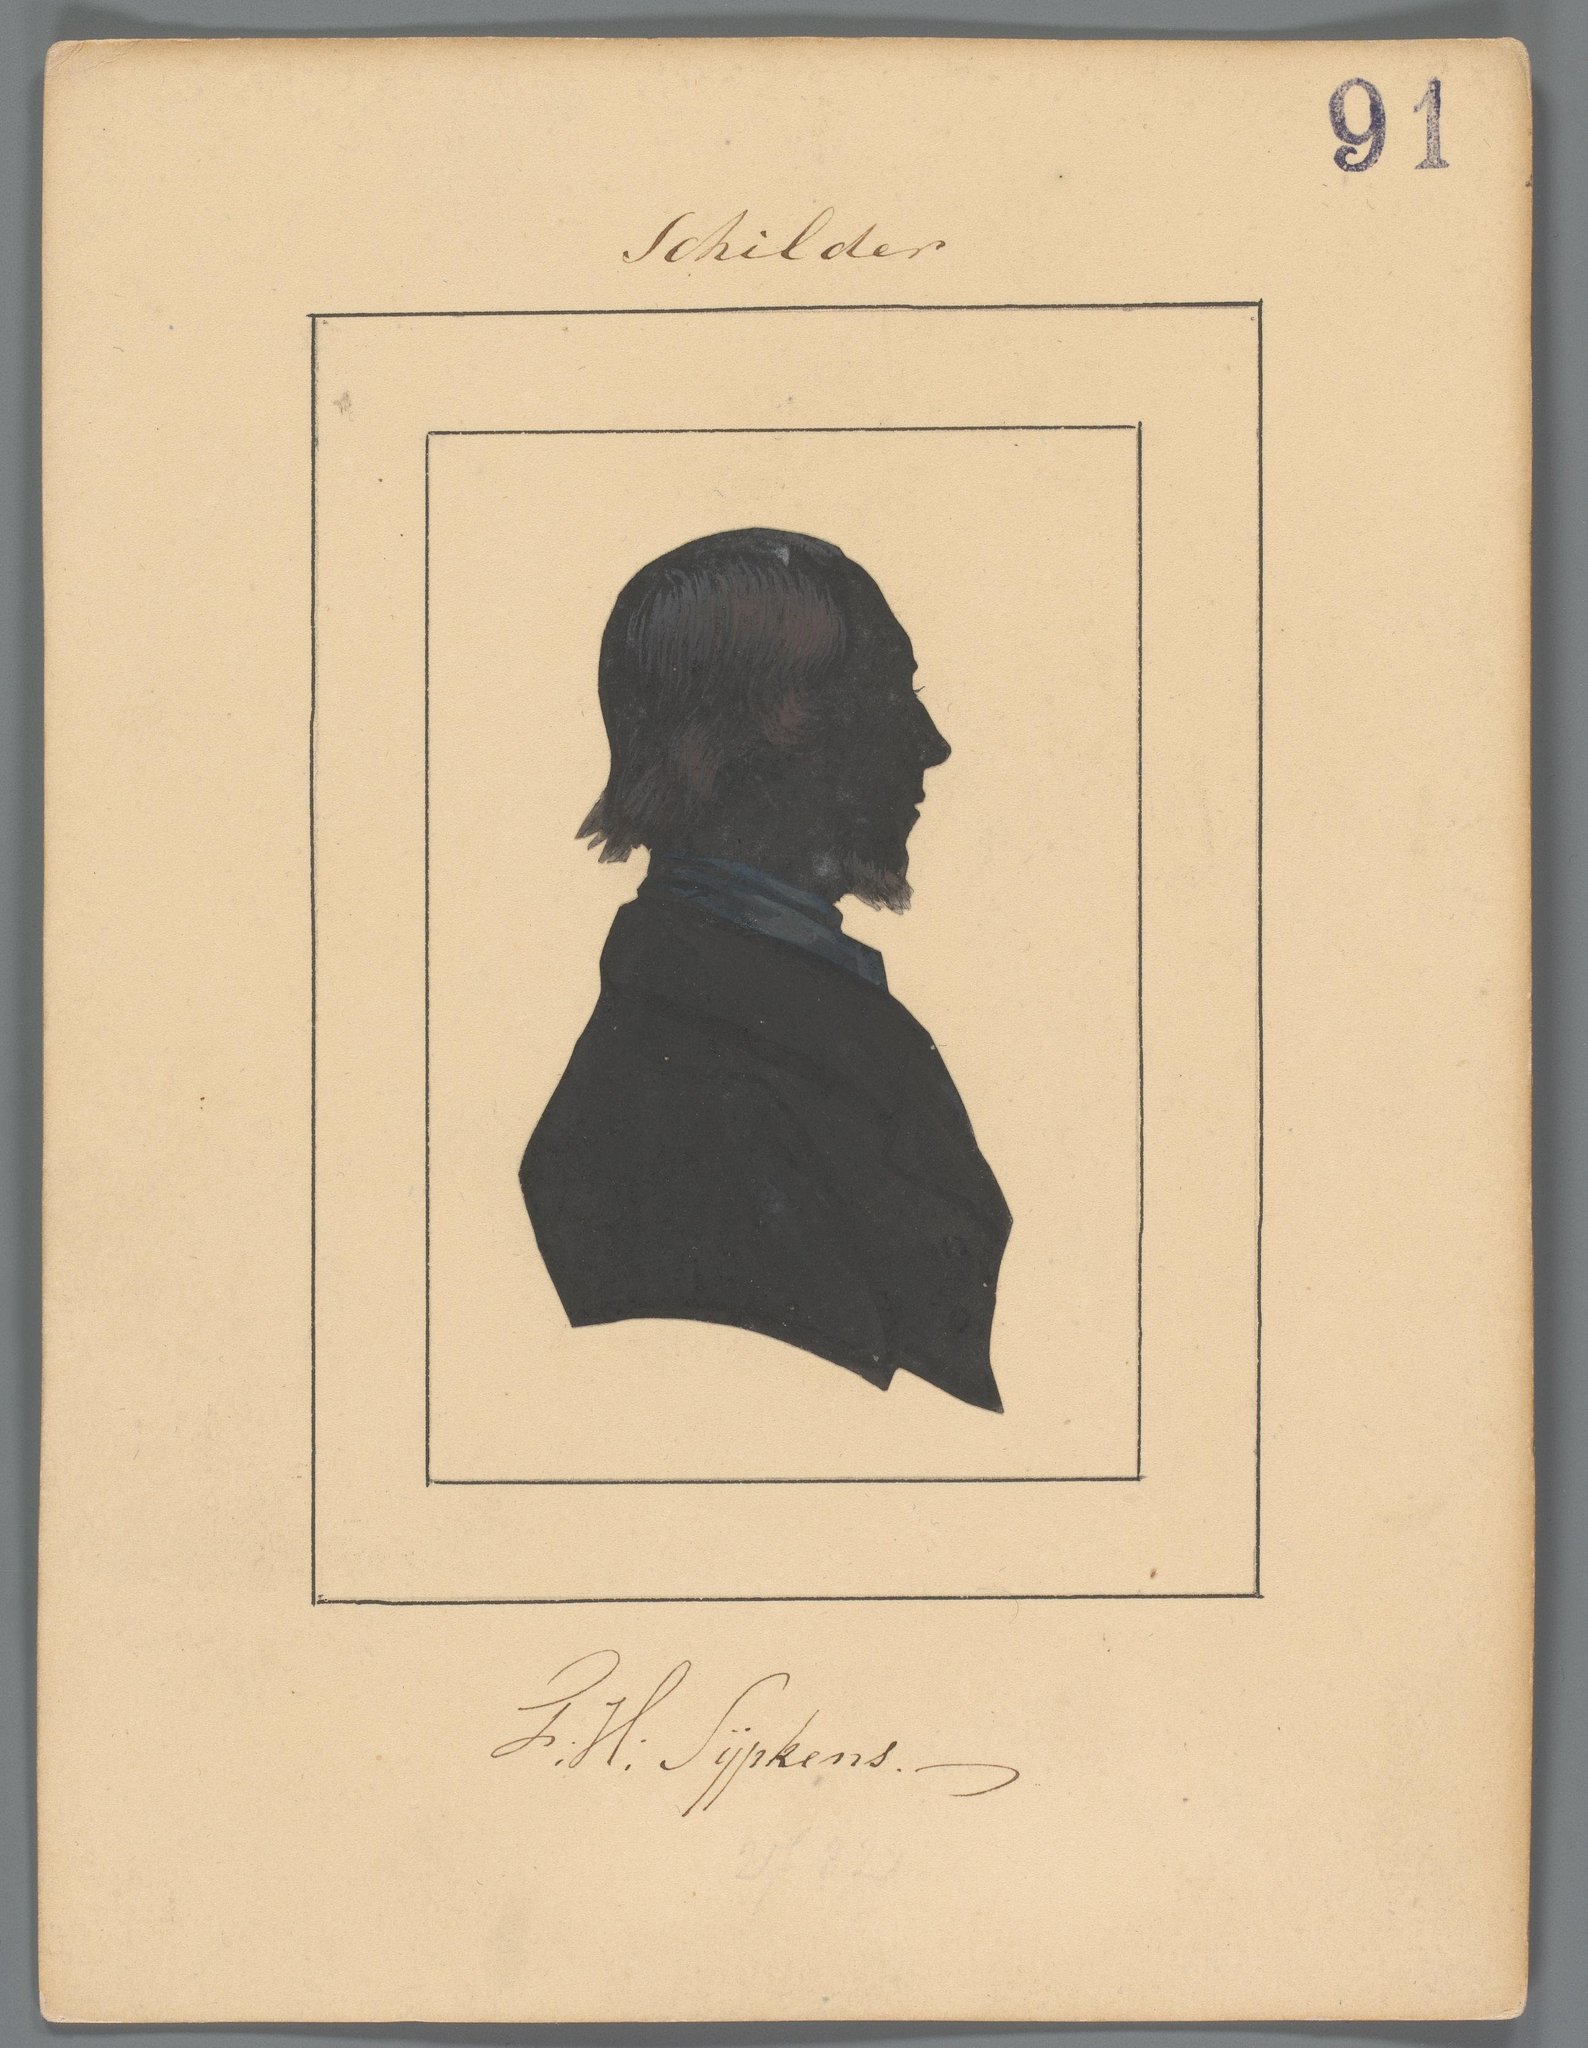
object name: silhouette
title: Silhouetportret van Ferdinand Hendrik Sijpkens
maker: elisabeth alida haanen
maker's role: draughtsman, print maker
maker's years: 1809-1845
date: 1819-1845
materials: ink, paint, paper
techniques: brush, snipping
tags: ferdinand hendrik sijpkens, historical persons, portrait, self-portrait of painter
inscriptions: number: ‘91’, inscription: ‘F:H: Sijpkens.’, collector's mark: ‘Ex-libris van Beresteyn’, inscription: ‘Neg. D. 1722’, inscription: ‘Schilder’, number: ‘13954’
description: Met onder het portret de handtekening van de geportretteerde.